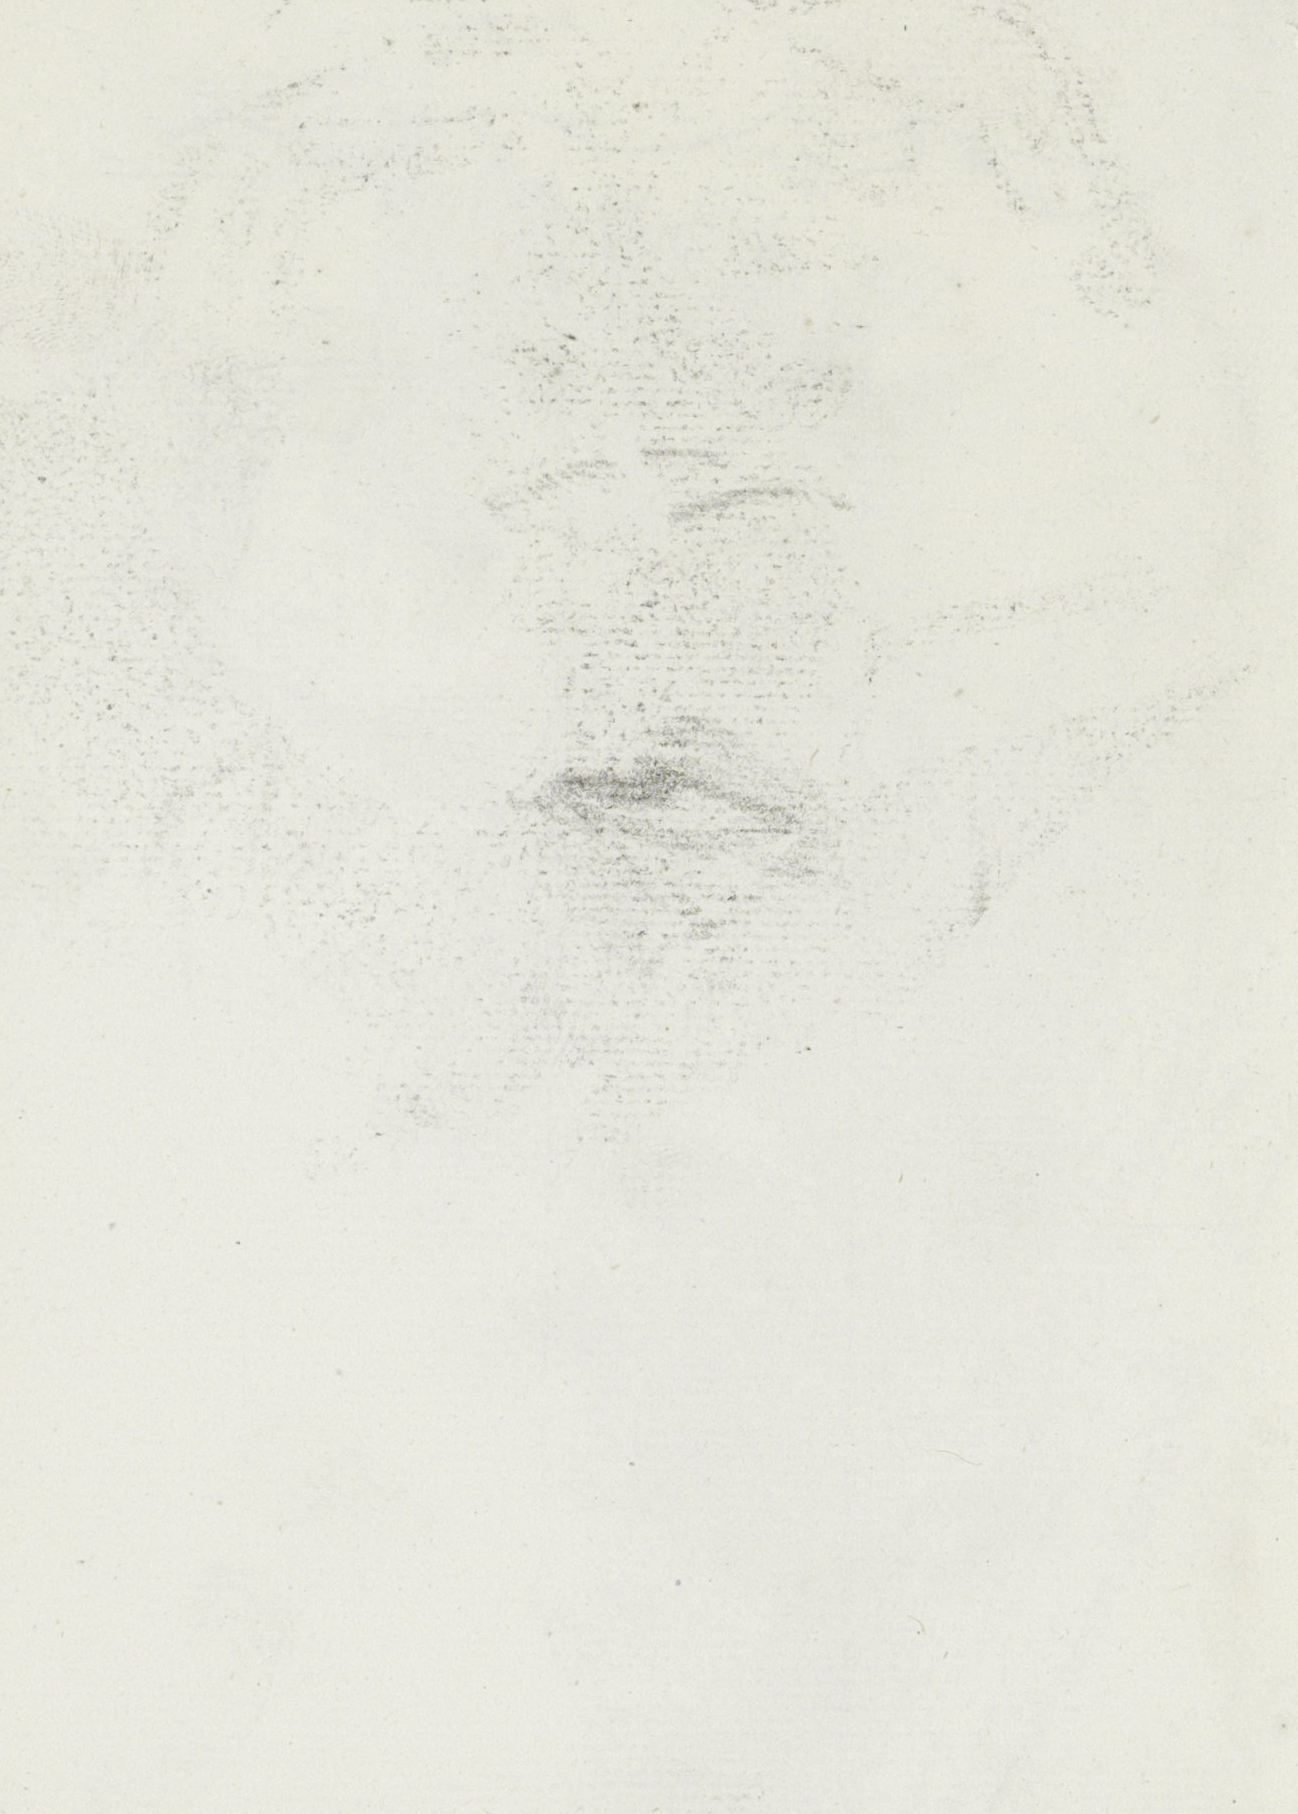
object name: sketchbook leaf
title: Abklatsch van de krijttekening op pagina 9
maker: isaac israels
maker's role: draughtsman, painter, print maker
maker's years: 1865-1934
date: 1886-1903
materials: paper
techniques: printmaking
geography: amsterdam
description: Pagina 8 uit schetsboek XXXVII met 52 pagina's.